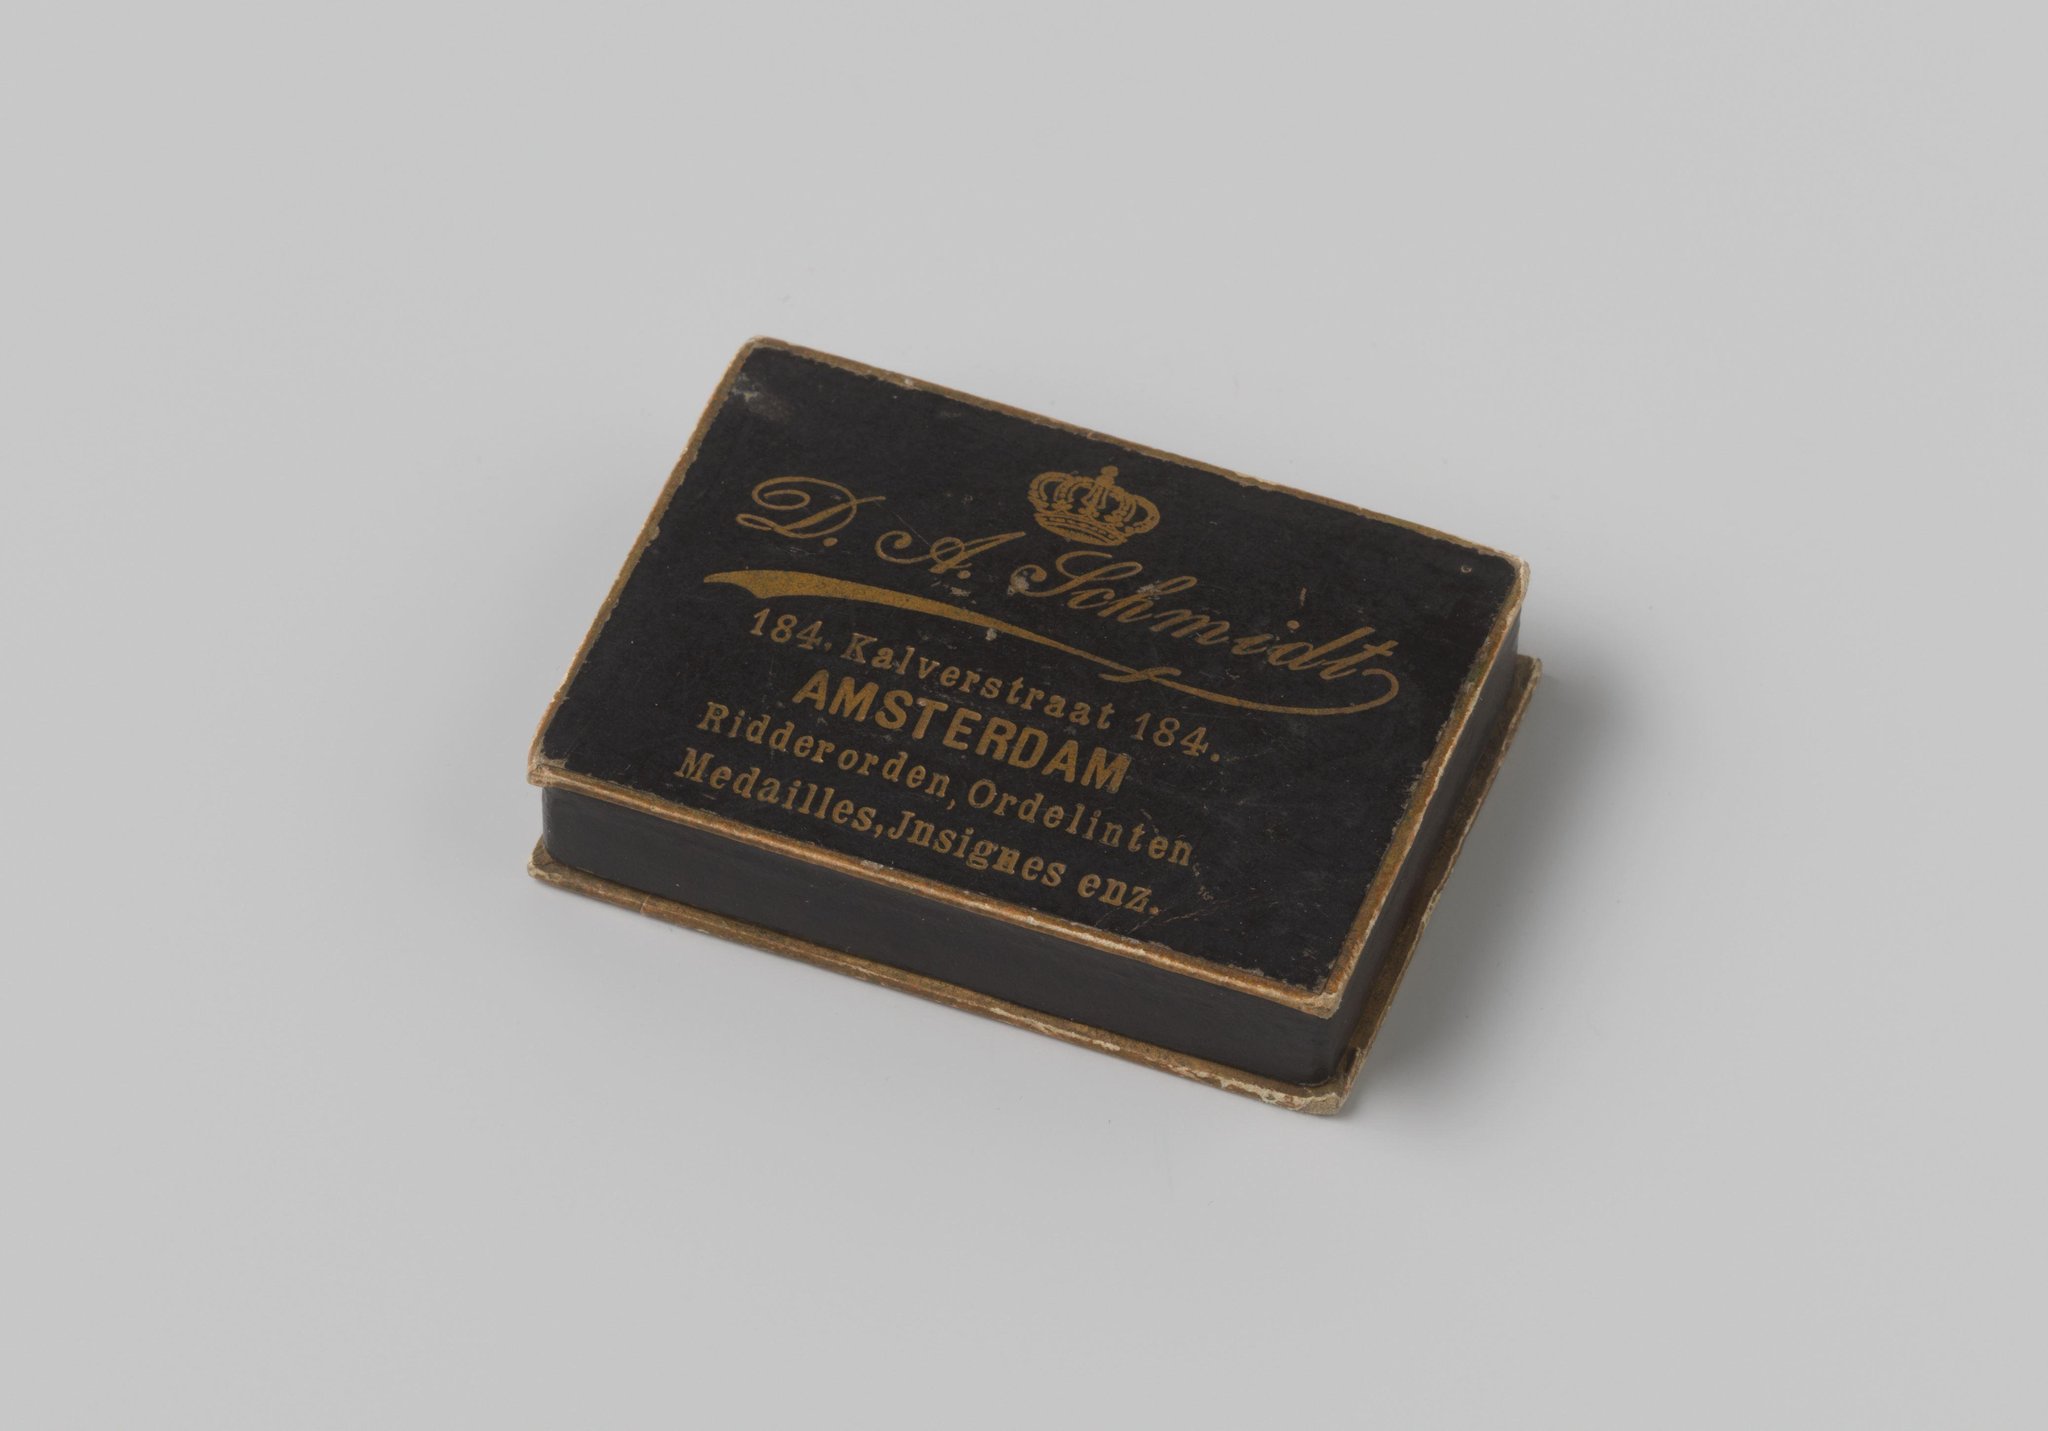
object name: medal box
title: Doosje bij draagteken, 1910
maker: Anonymous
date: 1910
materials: cardboard, ink, velvet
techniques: printing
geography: netherlands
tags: the hague, amsterdam, sculptor, bart van hove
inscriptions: inscription: ‘D.A. Schmidt 184 Kalverstraat 184 AMSTERDAM Ridderorden, Ordelinten Medailles, Insignes enz.’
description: Rechthoekig zwart kartonnen doosje met goudkleurige randen, bestaande uit twee losse delen. Deksel v.z.v. goudkleurige gekroond opschrift. Binnenzijde met paars fluweel. Onderkant doosje wit.